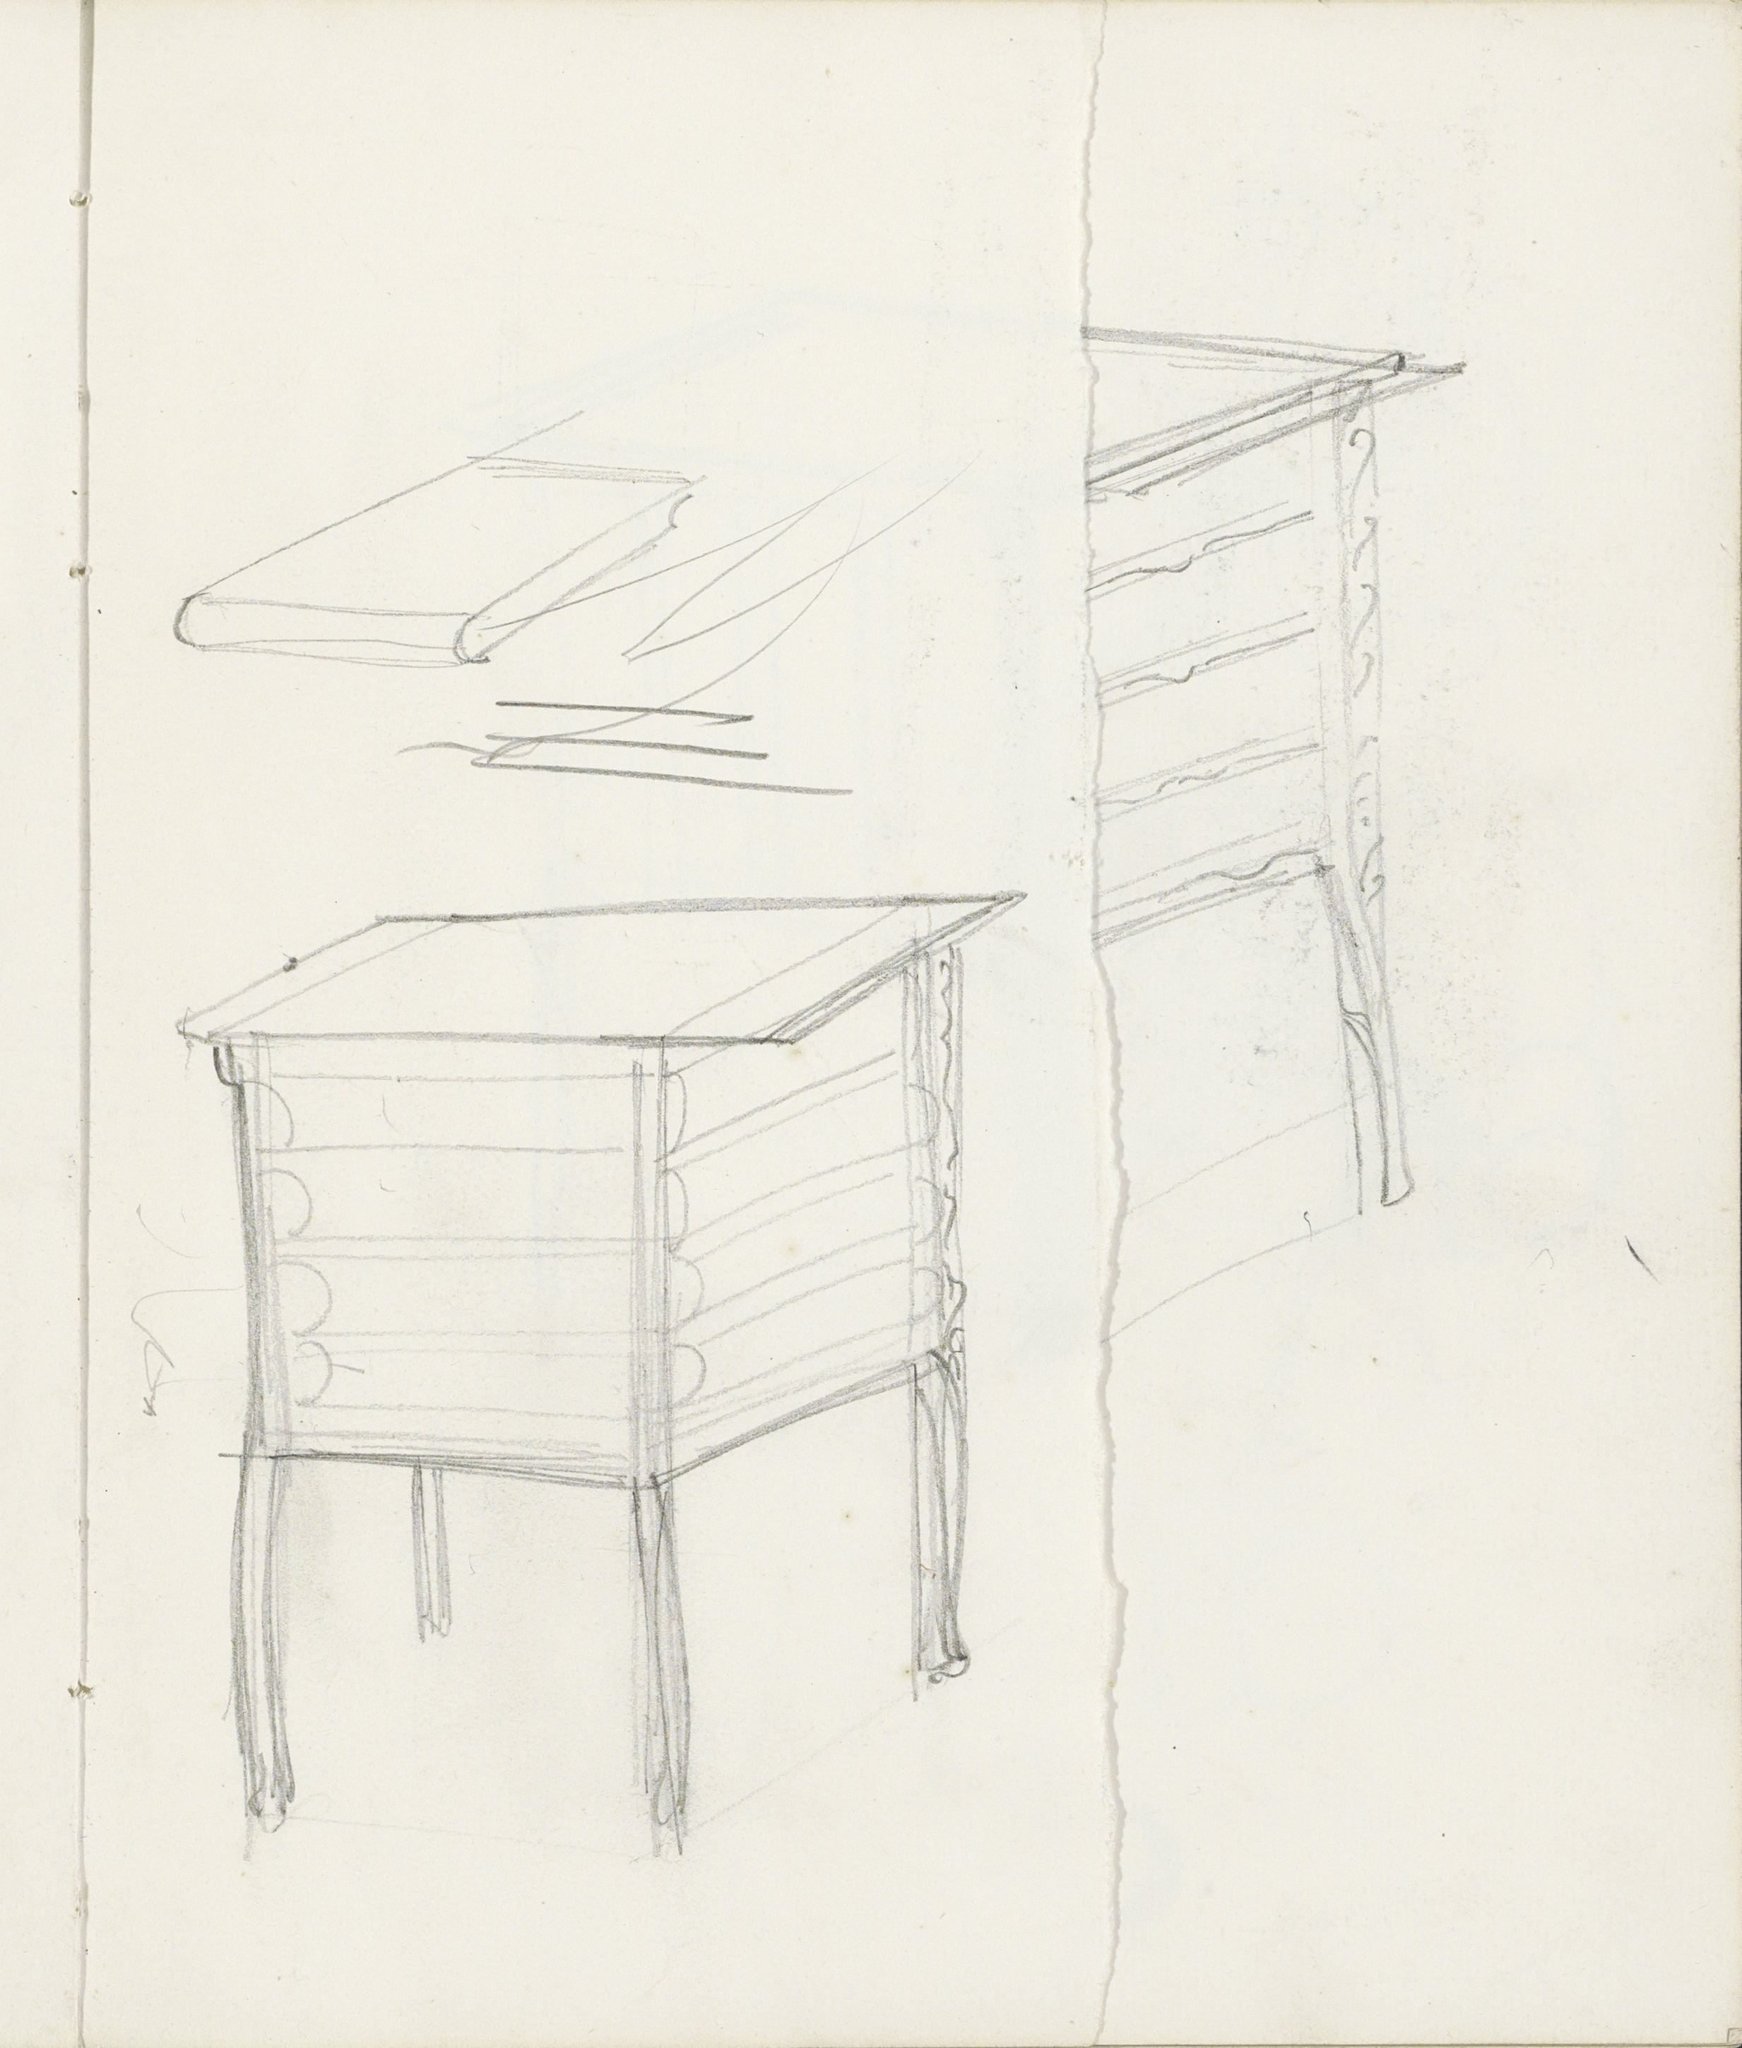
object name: sketchbook leaf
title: Ontwerp voor een kast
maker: carel adolph lion cachet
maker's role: draughtsman, print maker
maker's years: 1864-1945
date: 1900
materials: paper, pencil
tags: furniture for storage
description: De pagina is voor de helft uit het schetsboek gescheurd.